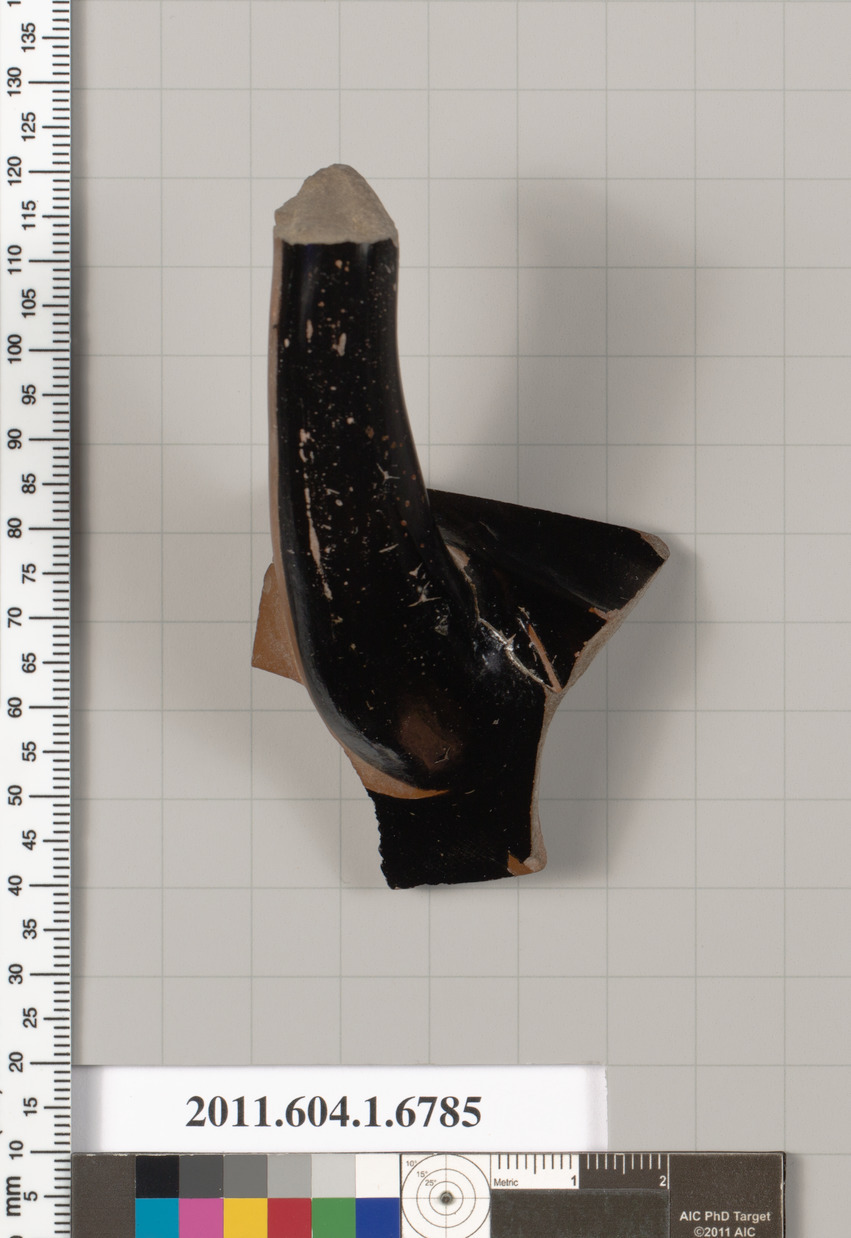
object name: kylix fragment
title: Terracotta fragment of a kylix (drinking cup)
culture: greek, attic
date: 490-470 BCE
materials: terracotta